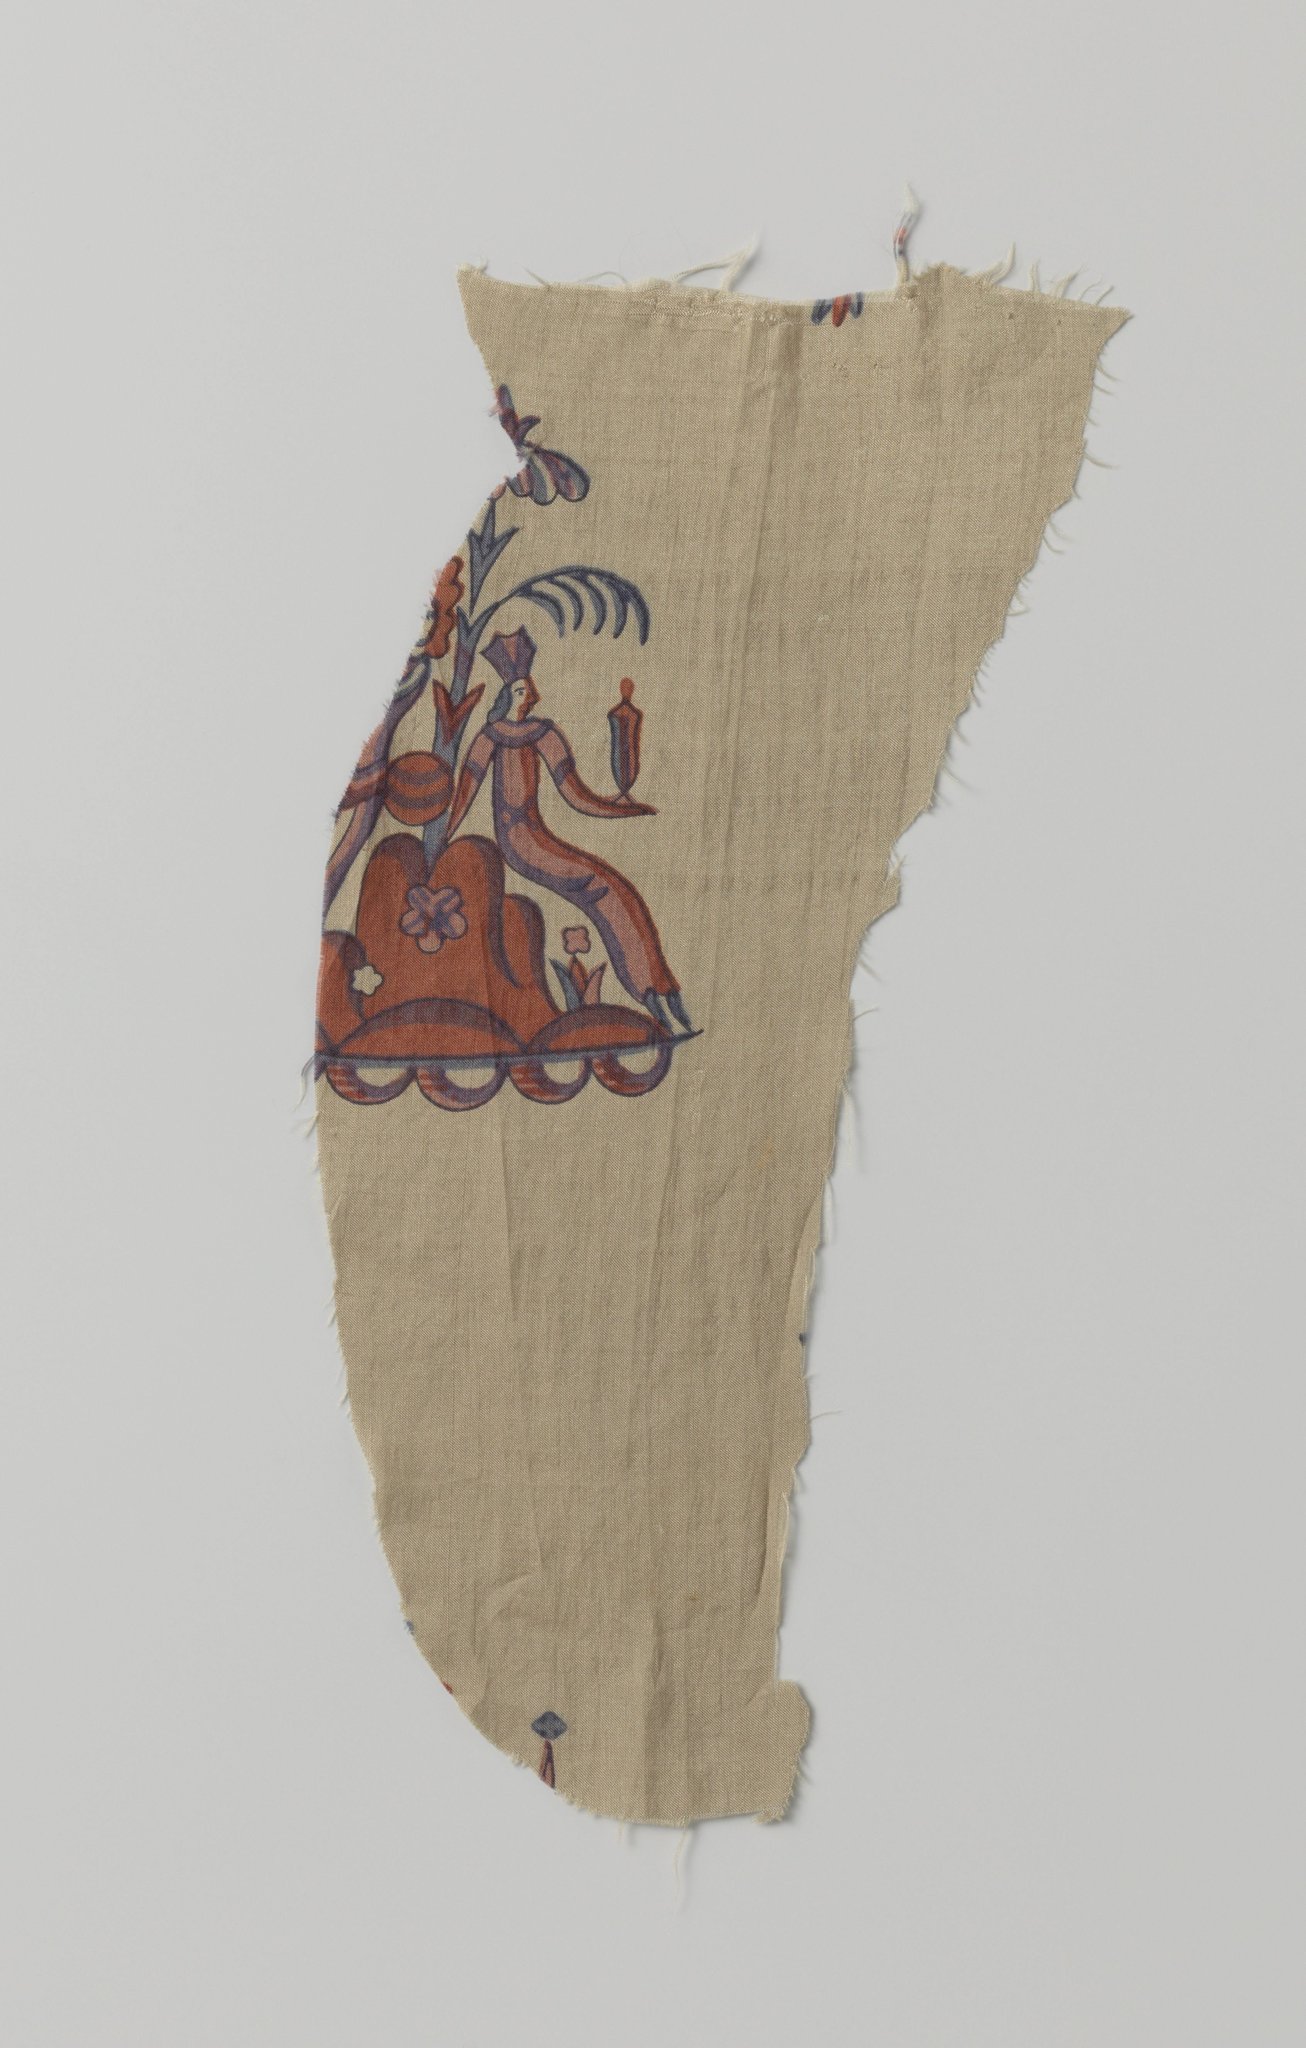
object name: fragment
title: Fragment zijdeweefsel met opgedrukt patroon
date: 1920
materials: silk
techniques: printing block, weave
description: Fragment zijdeweefsel. Een beige of leverkleurige grond heeft een patroon van verspringende rijen met verschillende patronen. De ene rij heeft bloemtakken tussen een grond met een boom waaronder twee mensen, de andere rij heeft bloemtakken tussen een grond waarop twee staande figuren (man en vrouw?), in de kleuren blauw, roze en rood.